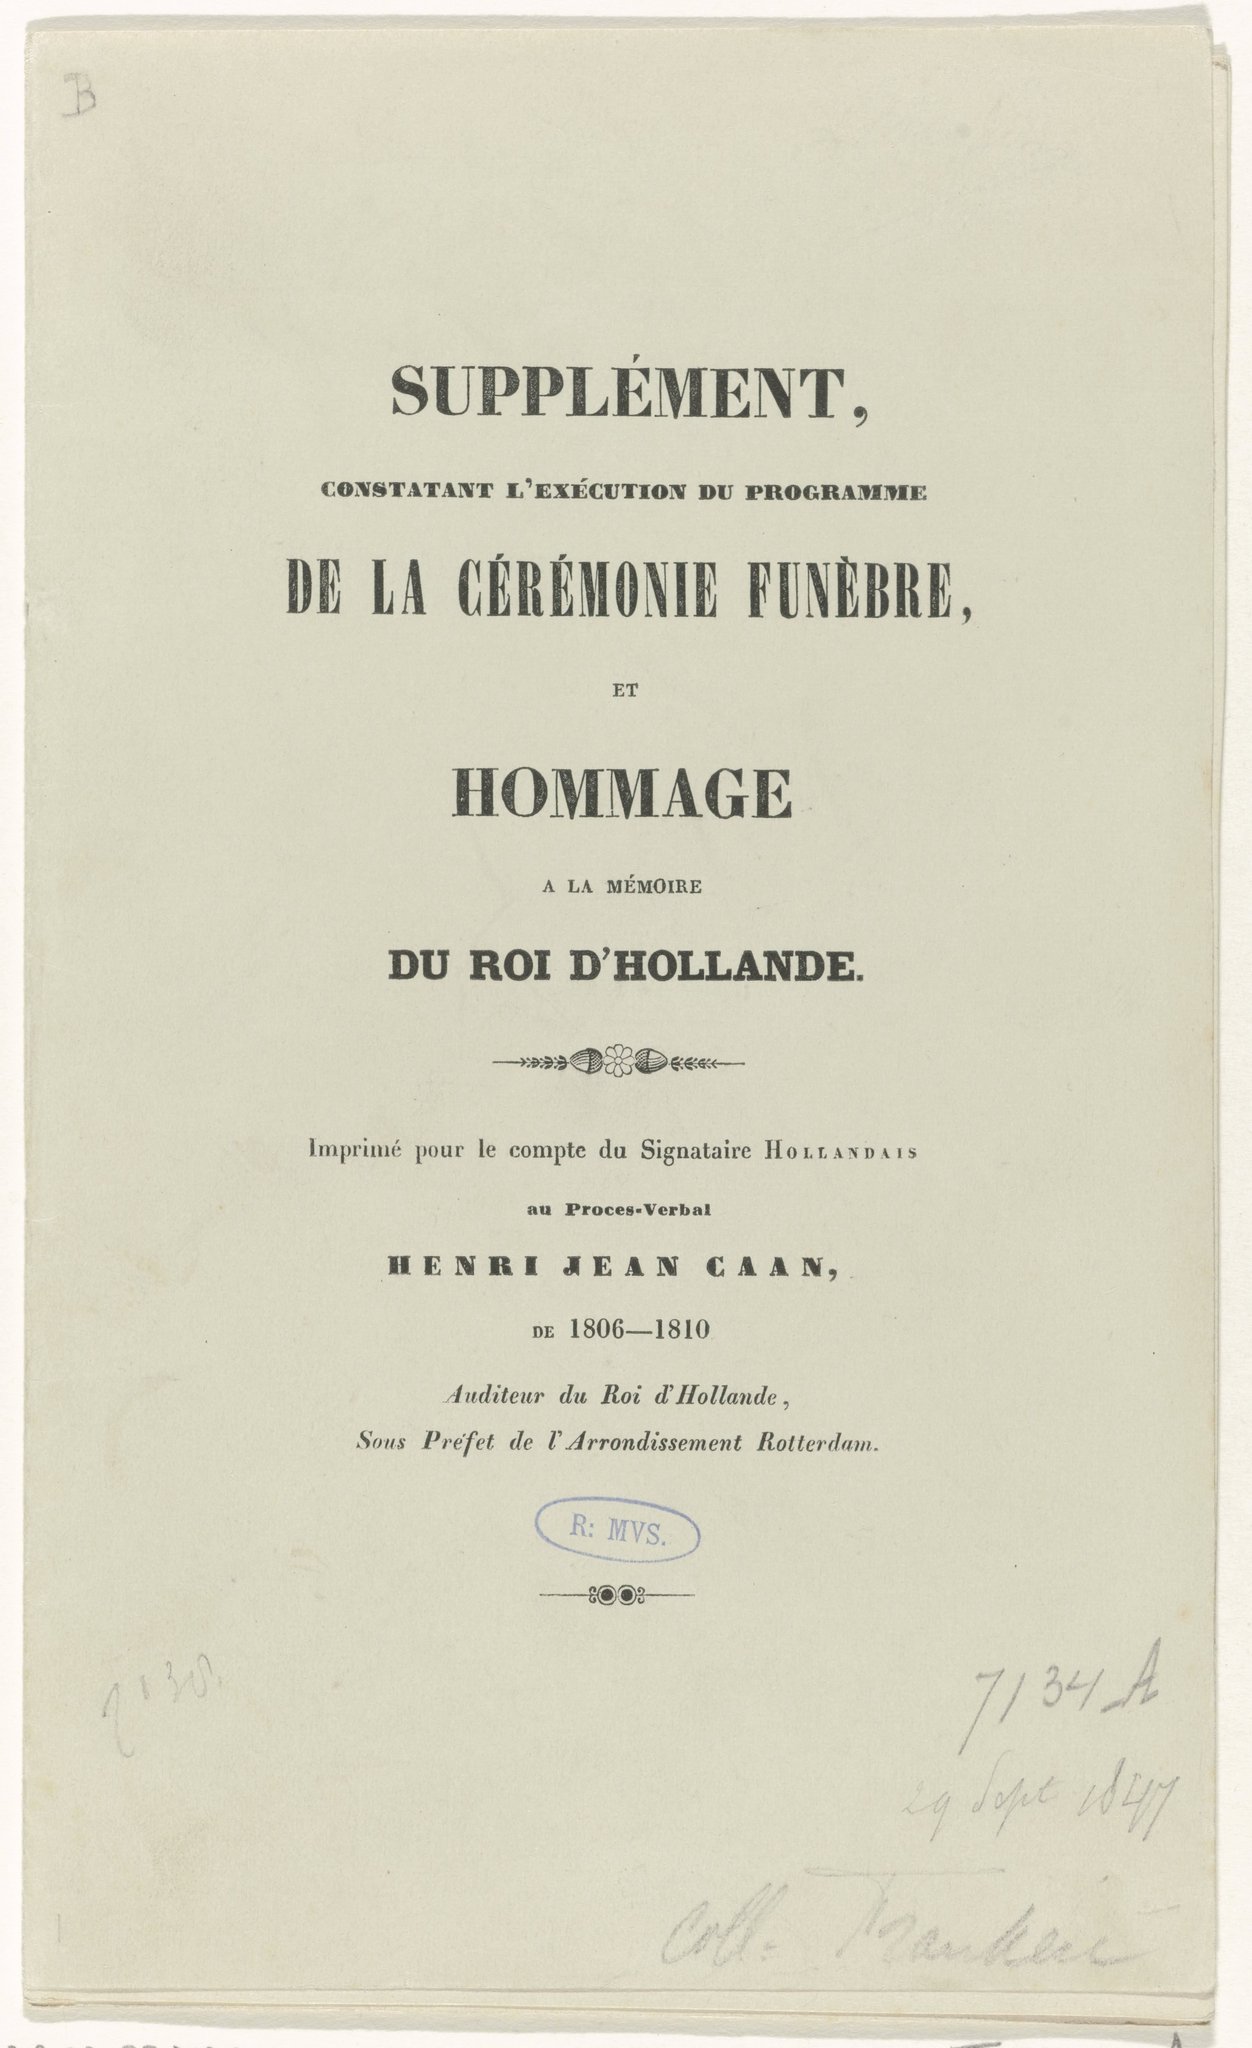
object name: programma, programmaboekje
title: Programmaboekje van een herdenkingsdienst voor Lodewijk Napoleon, 1847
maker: Anonymous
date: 1847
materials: paper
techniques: letterpress printing, lithograph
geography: netherlands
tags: louis napoleon (king of holland)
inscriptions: collector's mark: Lugt 2228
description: Programmaboekje voor een herdenkingsdienst voor de voormalige koning van Holland, Lodewijk Napoleon, op 29 september 1847 in de kerk van Saint-Leu-la-Forêt. Boekje van tien bladzijden, op de vierde bladzijde een portret van Lodewijk Napoleon.